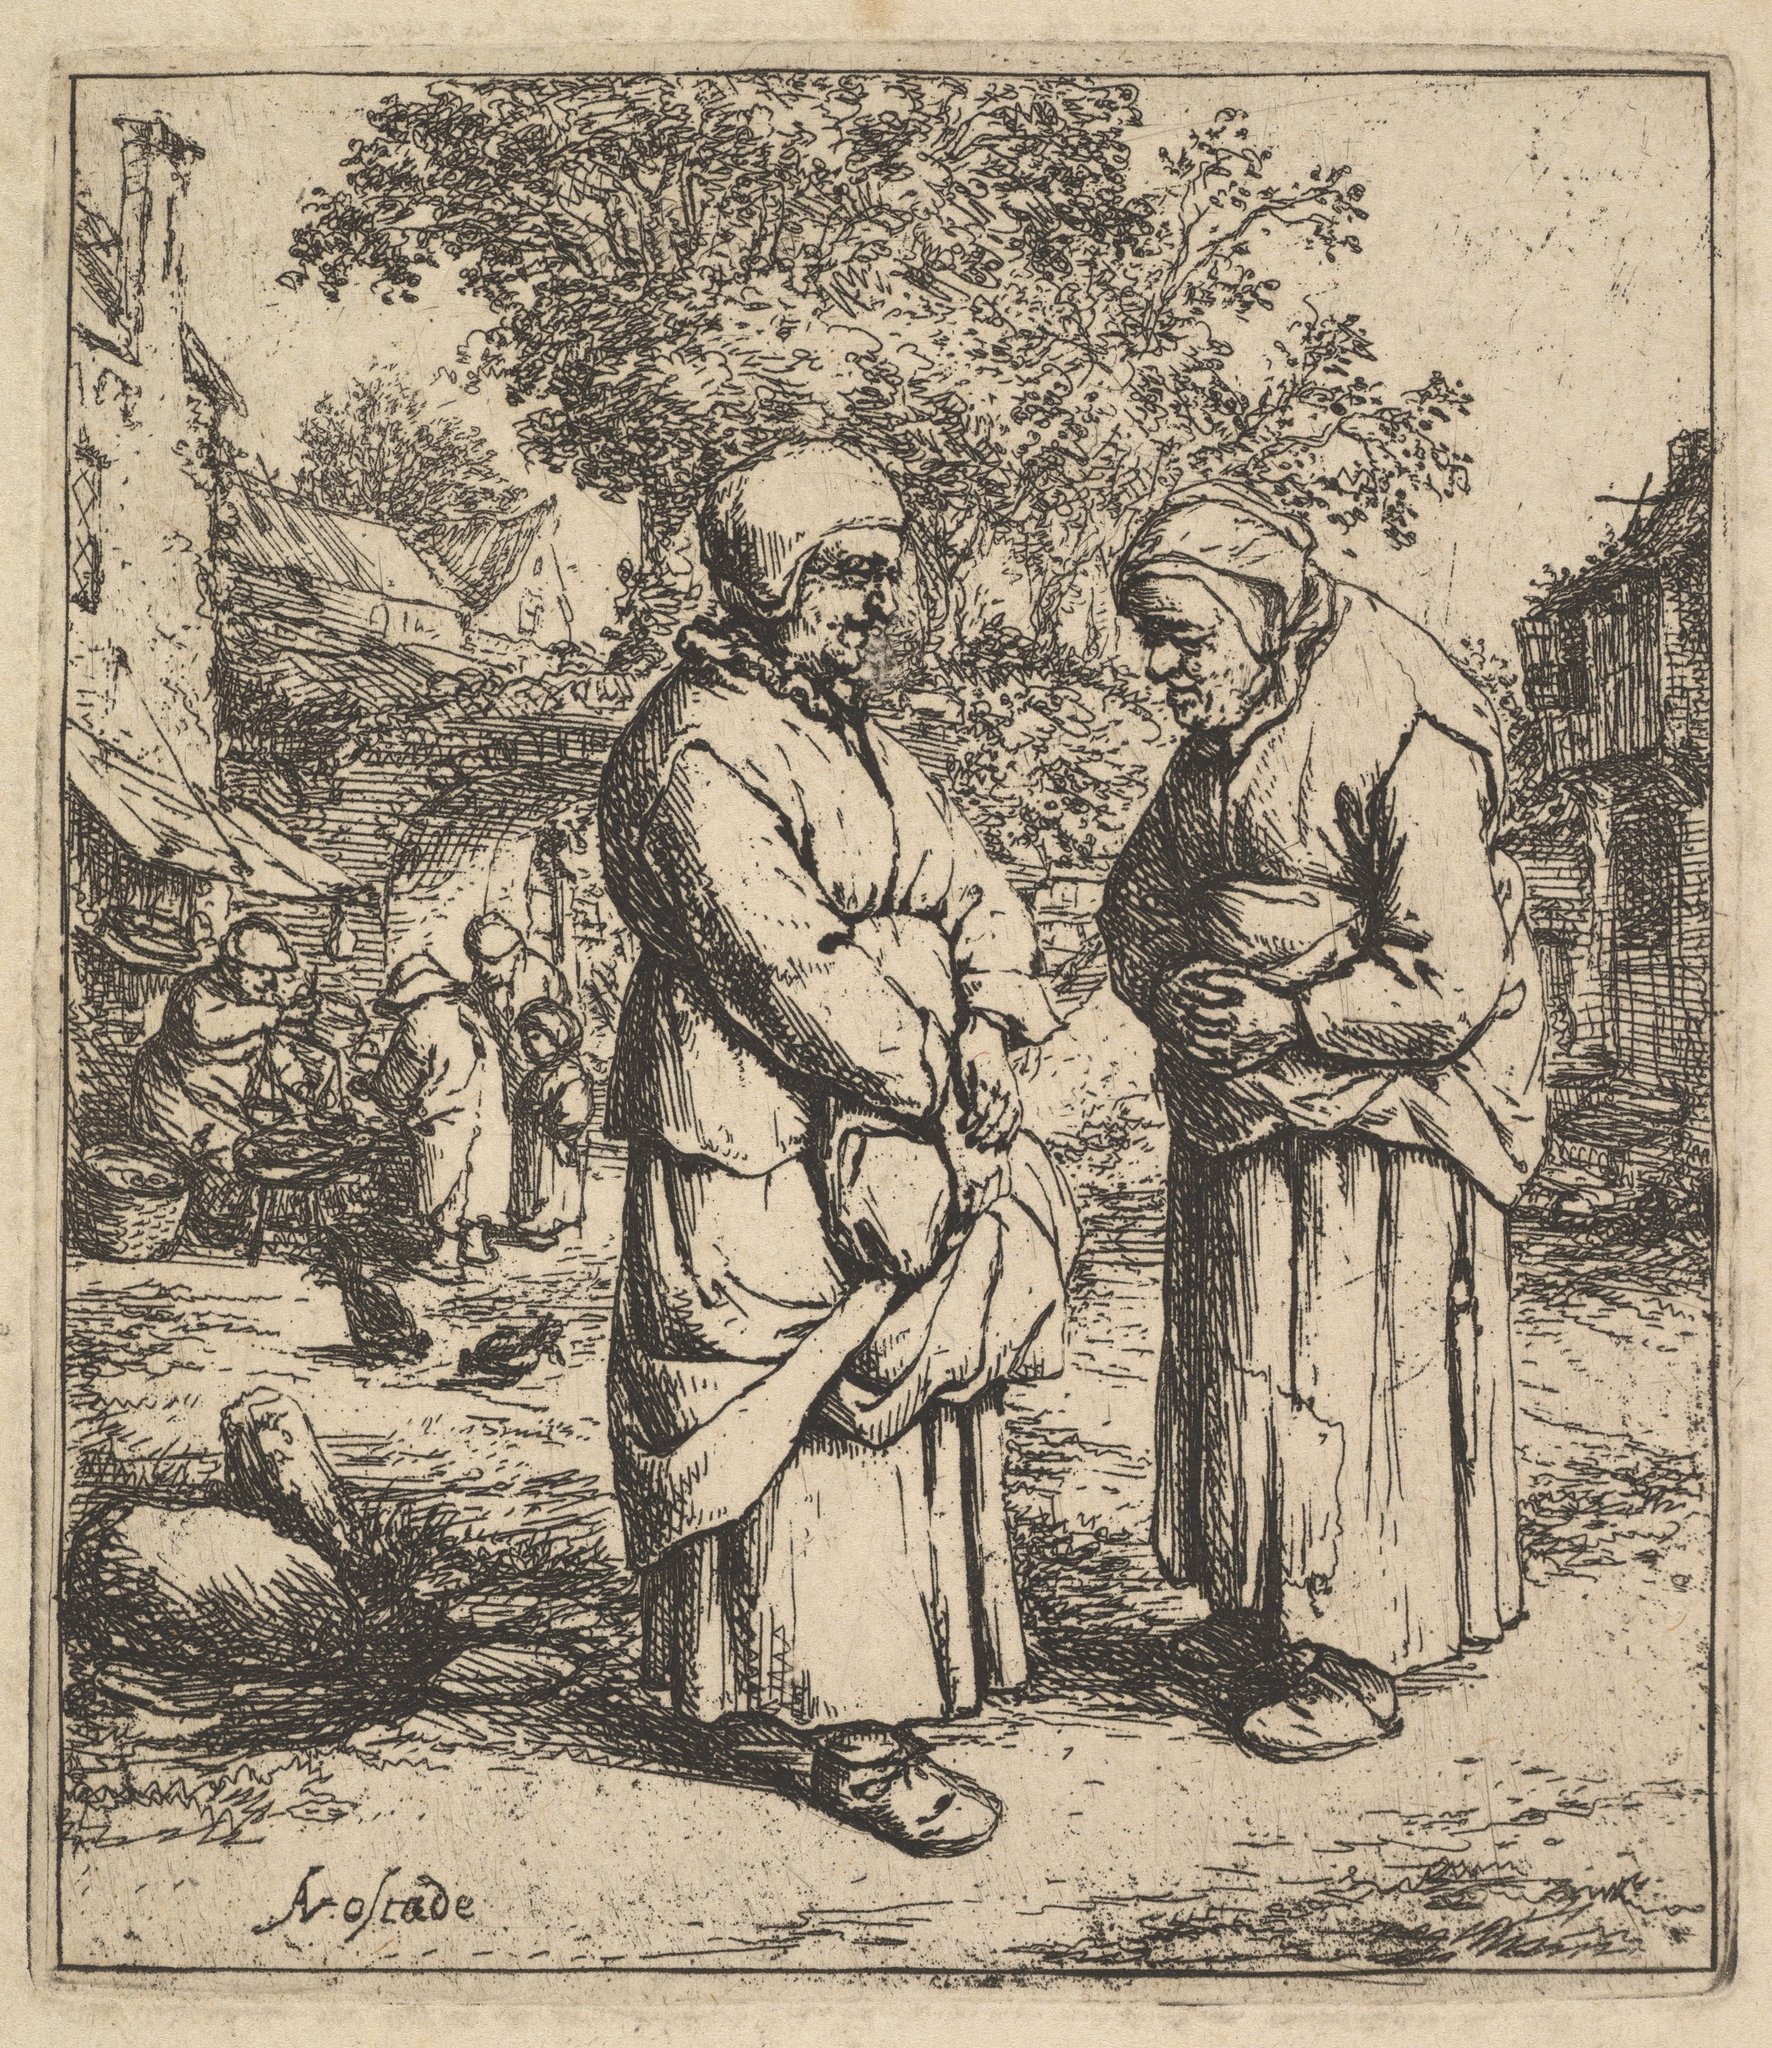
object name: print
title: Two Gossips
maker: adriaen van ostade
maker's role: artist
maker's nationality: dutch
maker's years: 1610-1685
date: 1610-1685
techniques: etching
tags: men